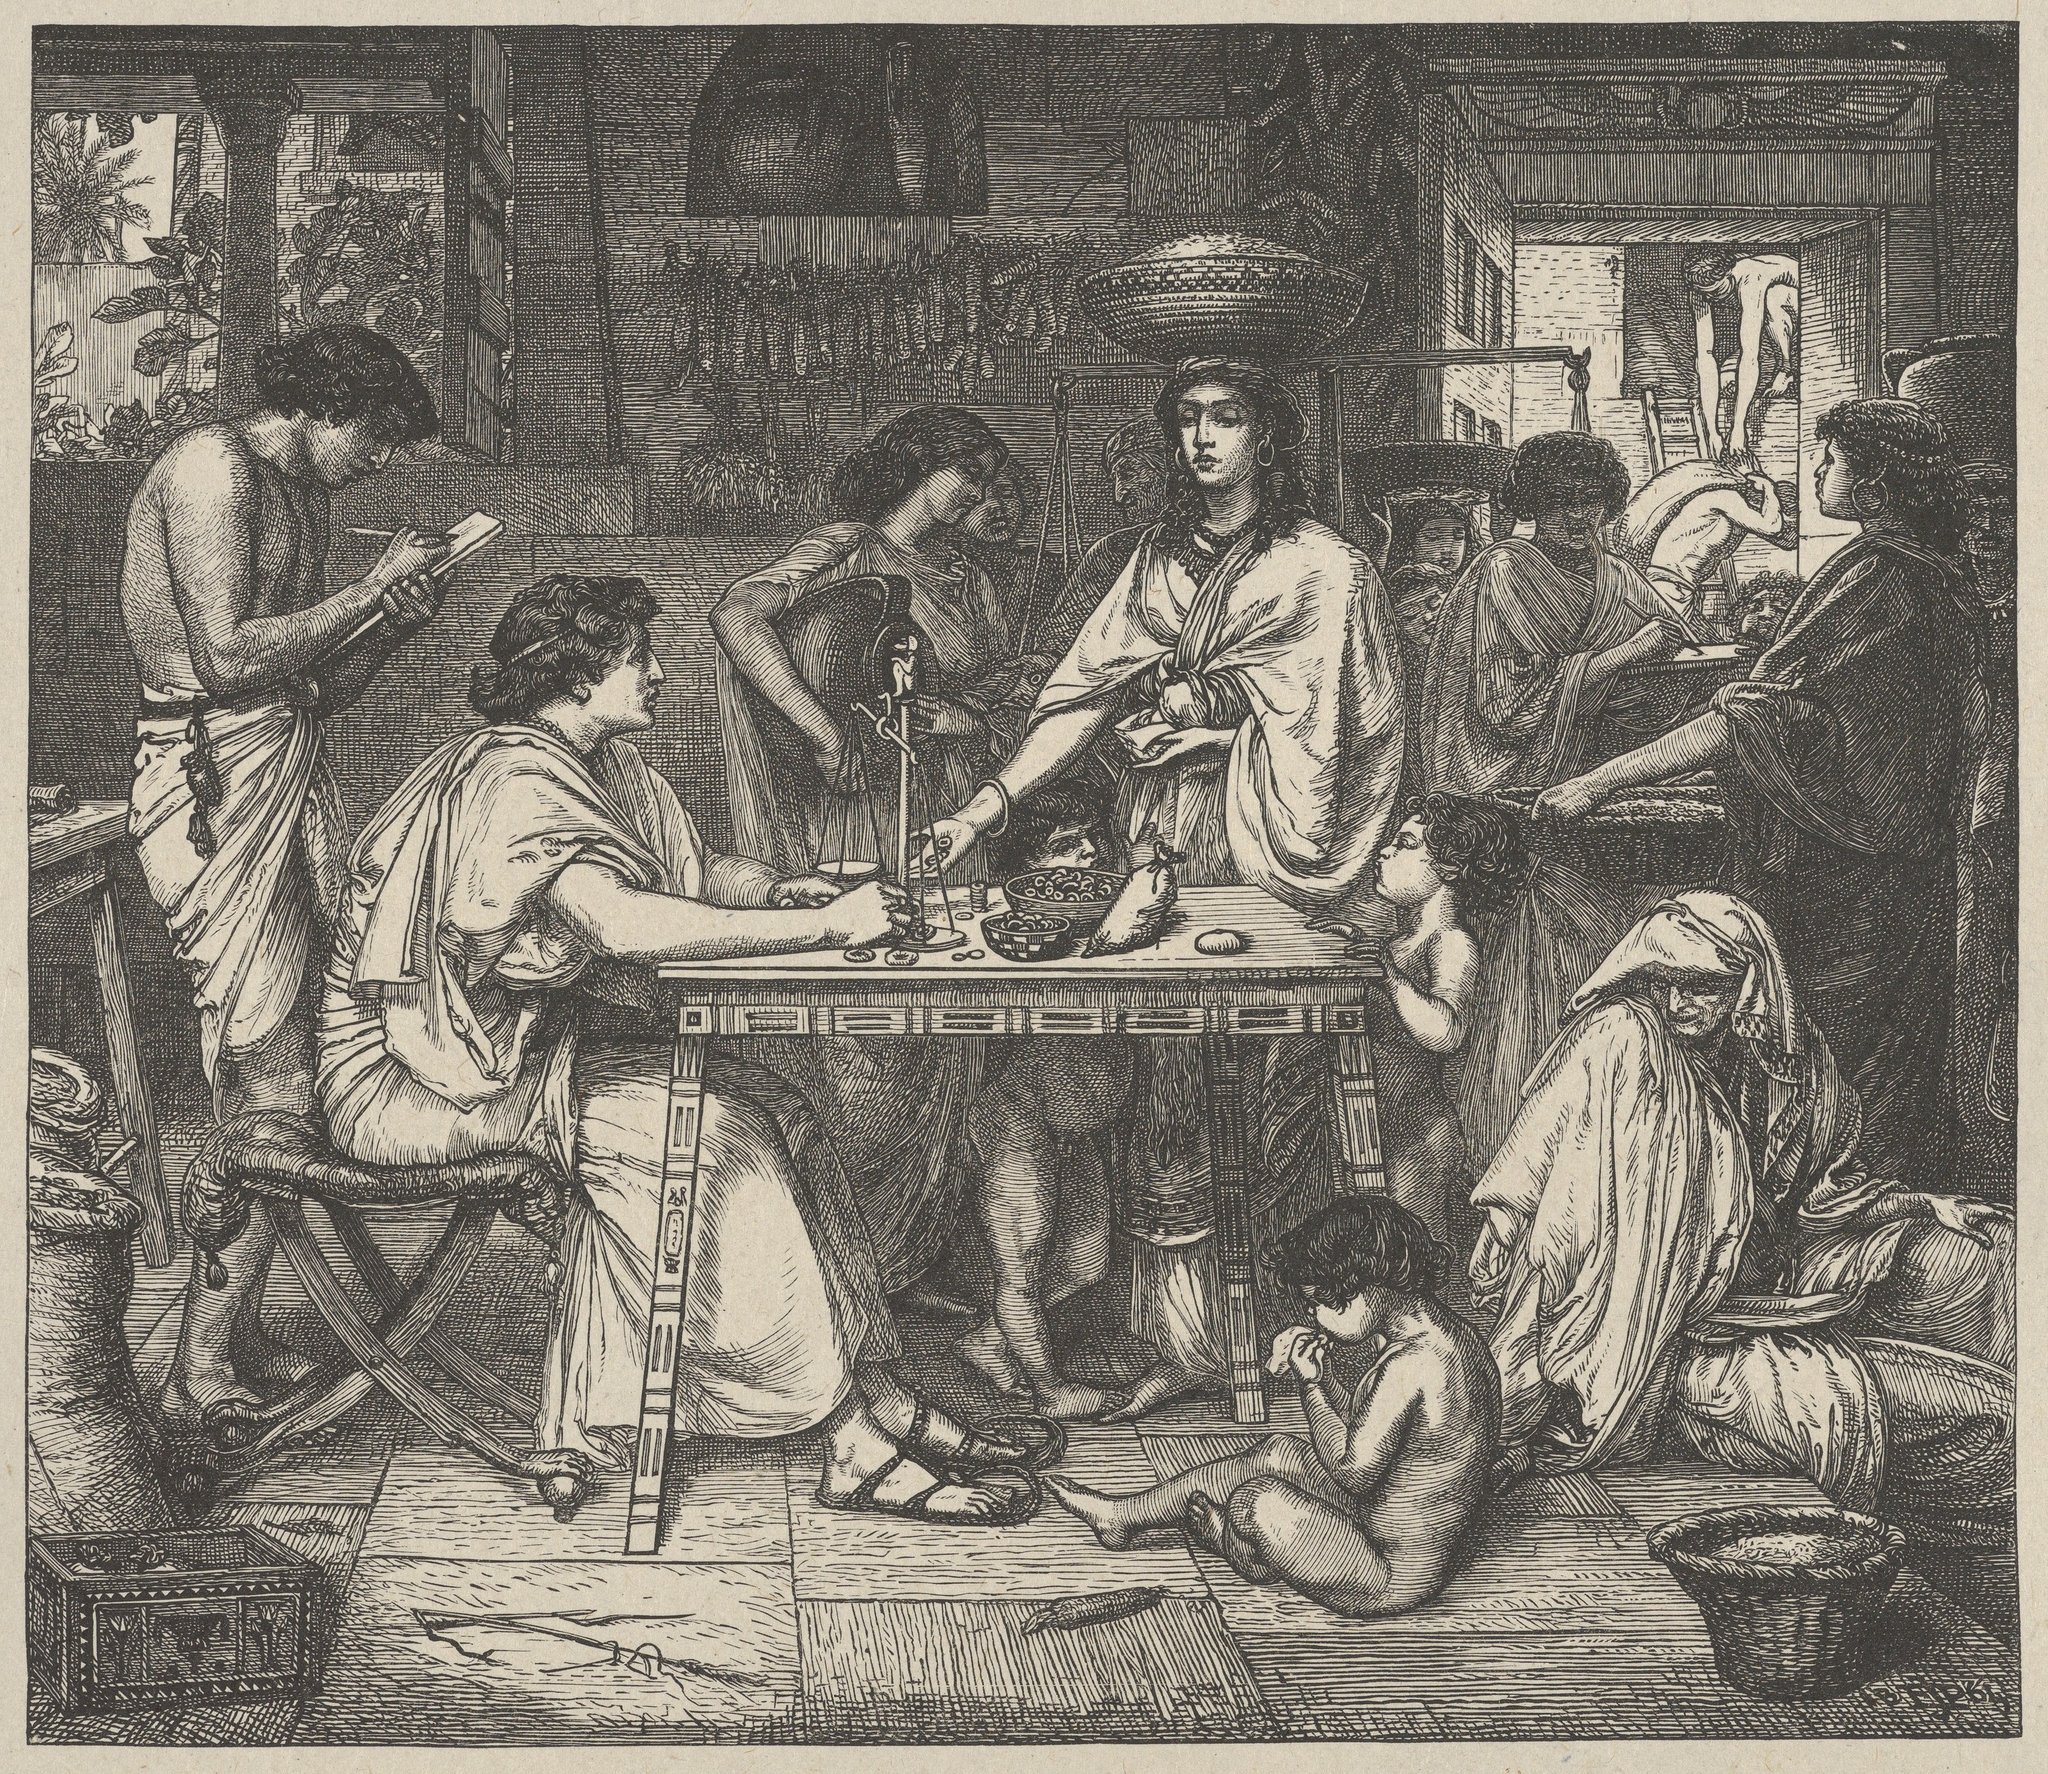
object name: print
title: Joseph Distributes Corn, from "Dalziels' Bible Gallery"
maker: sir edward john poynter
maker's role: artist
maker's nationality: british, born france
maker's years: 1836-1919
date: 1864-1881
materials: paper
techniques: engraving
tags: children,men,women,working